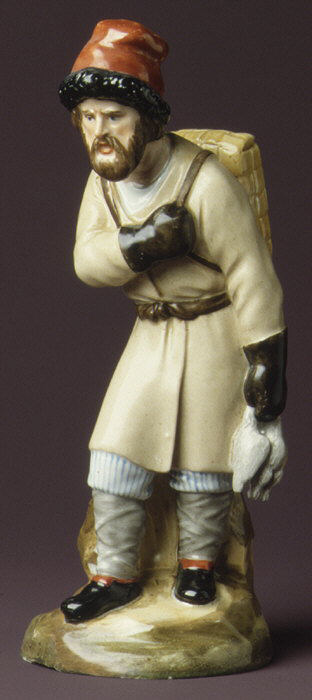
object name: figure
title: Poultry Seller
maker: imperial porcelain manufactory, st. petersburg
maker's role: manufactory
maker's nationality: russian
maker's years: 1744-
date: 1780-1800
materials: hard paste porcelain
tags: men,working